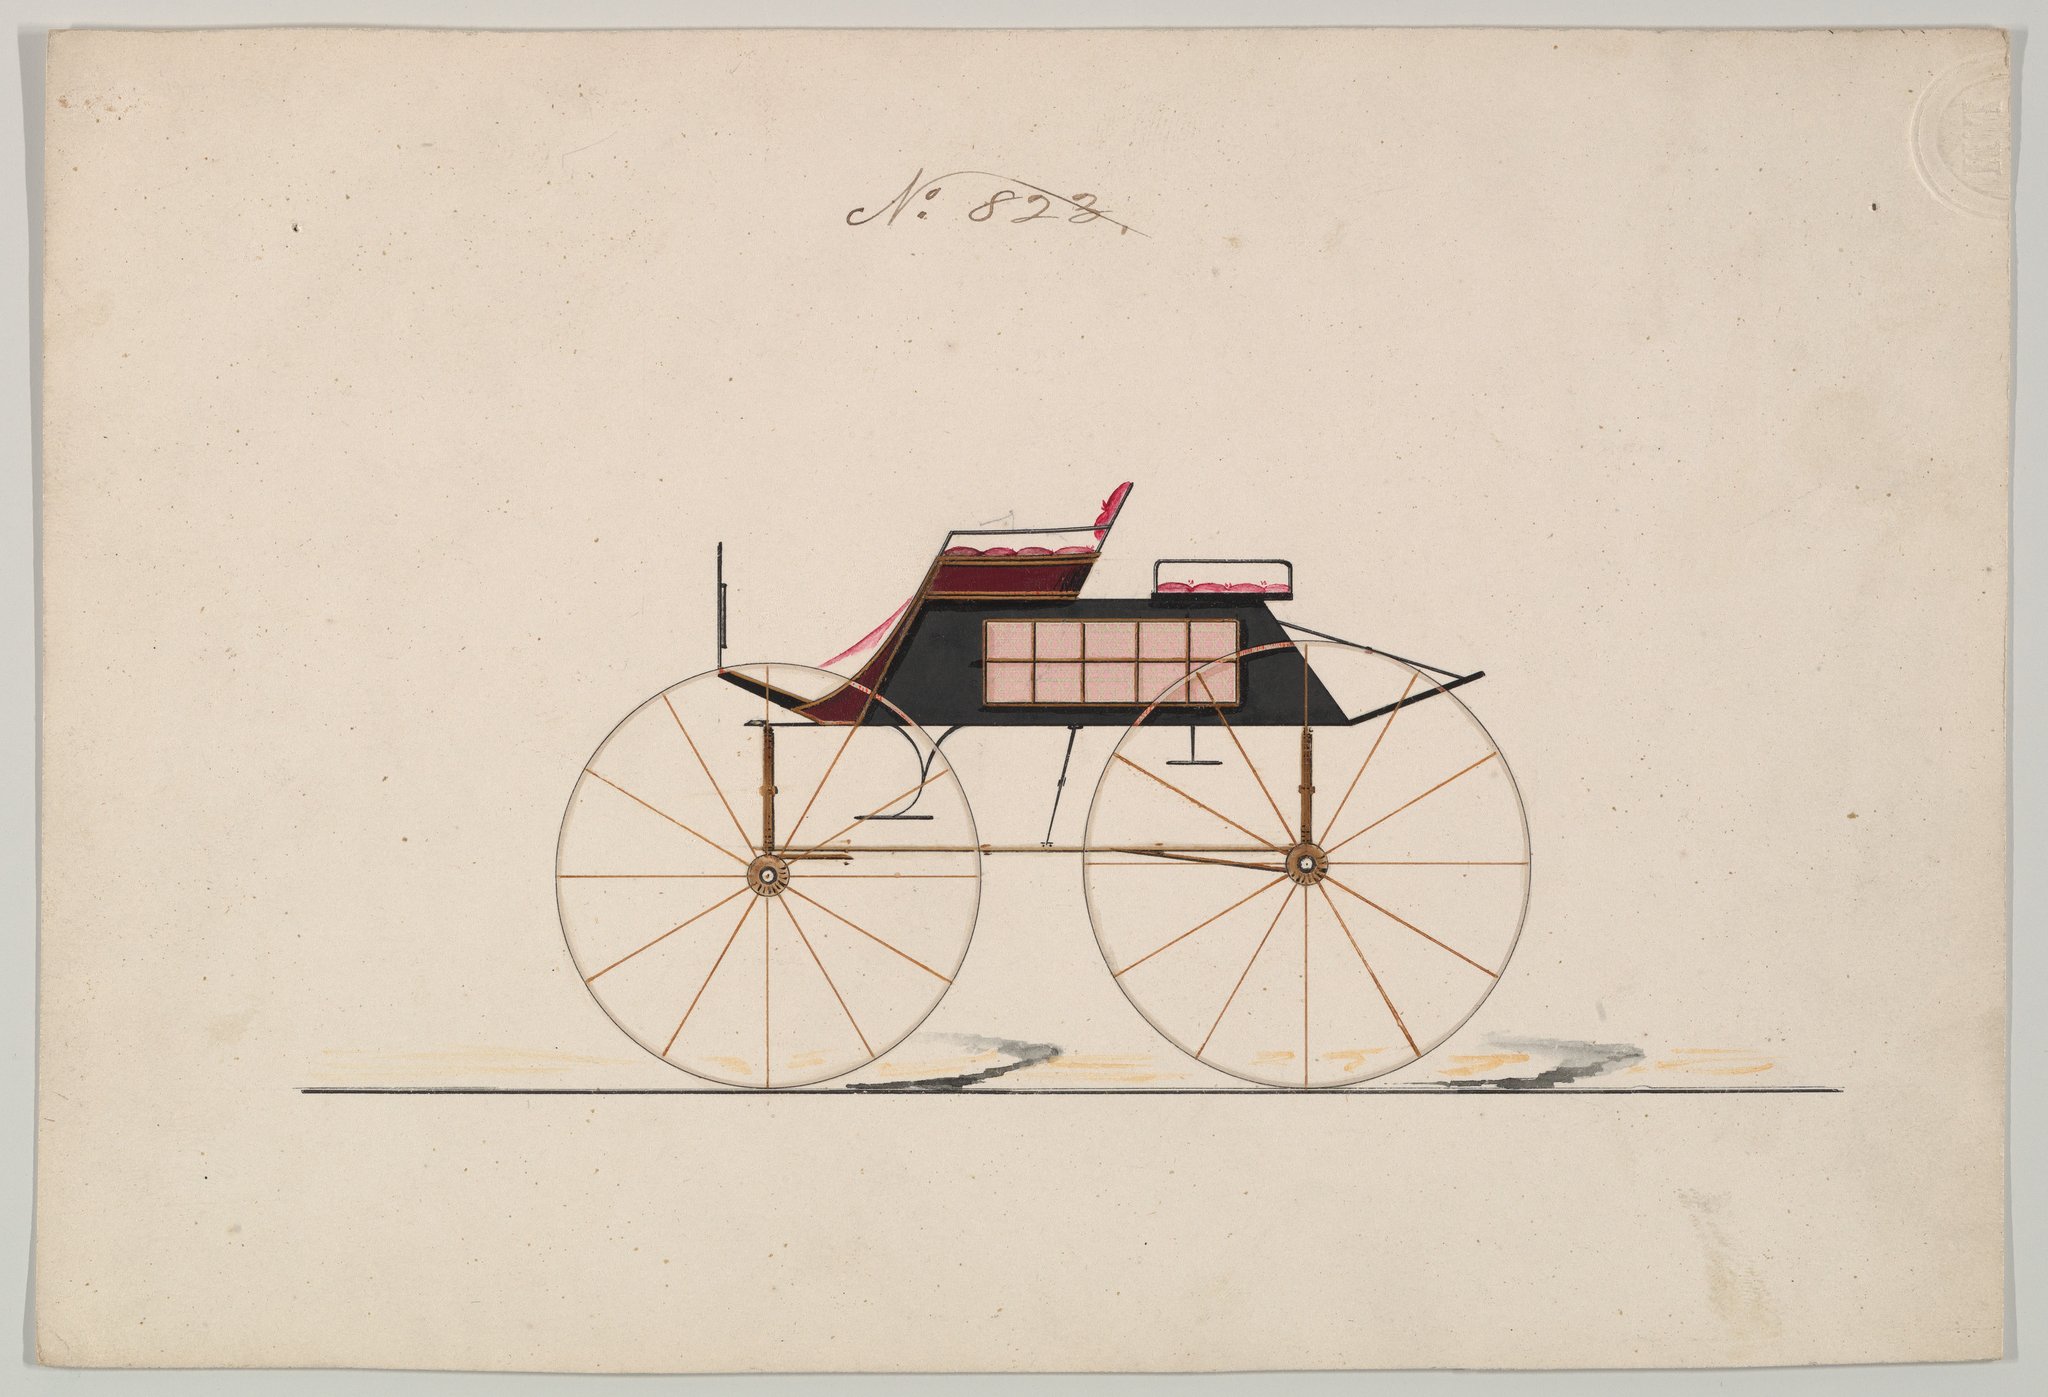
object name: drawing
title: Design for Wagon, no. 823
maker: brewster & co.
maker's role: manufacturer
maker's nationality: american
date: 1860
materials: gouache, gum arabic, ink, watercolor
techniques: pen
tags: carriages